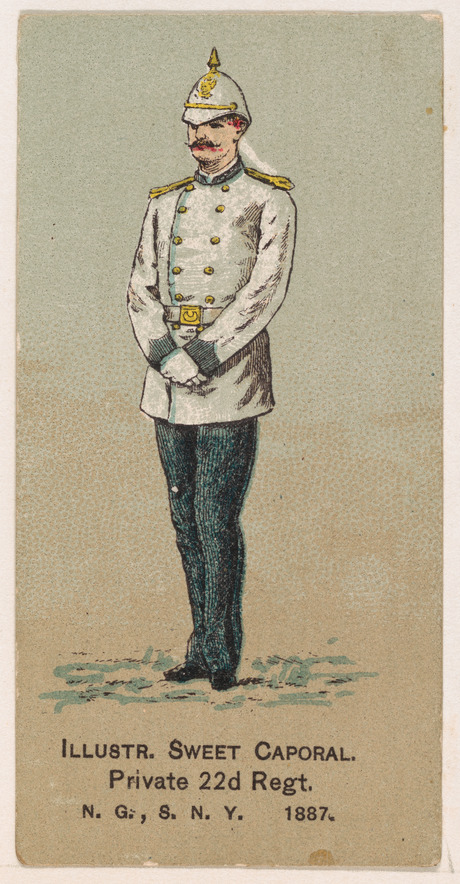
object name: print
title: Private, 22nd Regiment, National Guard of the State of New York, from the Military Series (N224) issued by Kinney Tobacco Company to promote Sweet Caporal Cigarettes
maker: kinney brothers tobacco company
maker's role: publisher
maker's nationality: american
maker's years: 1869-2011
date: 1888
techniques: color lithograph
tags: soldiers,men